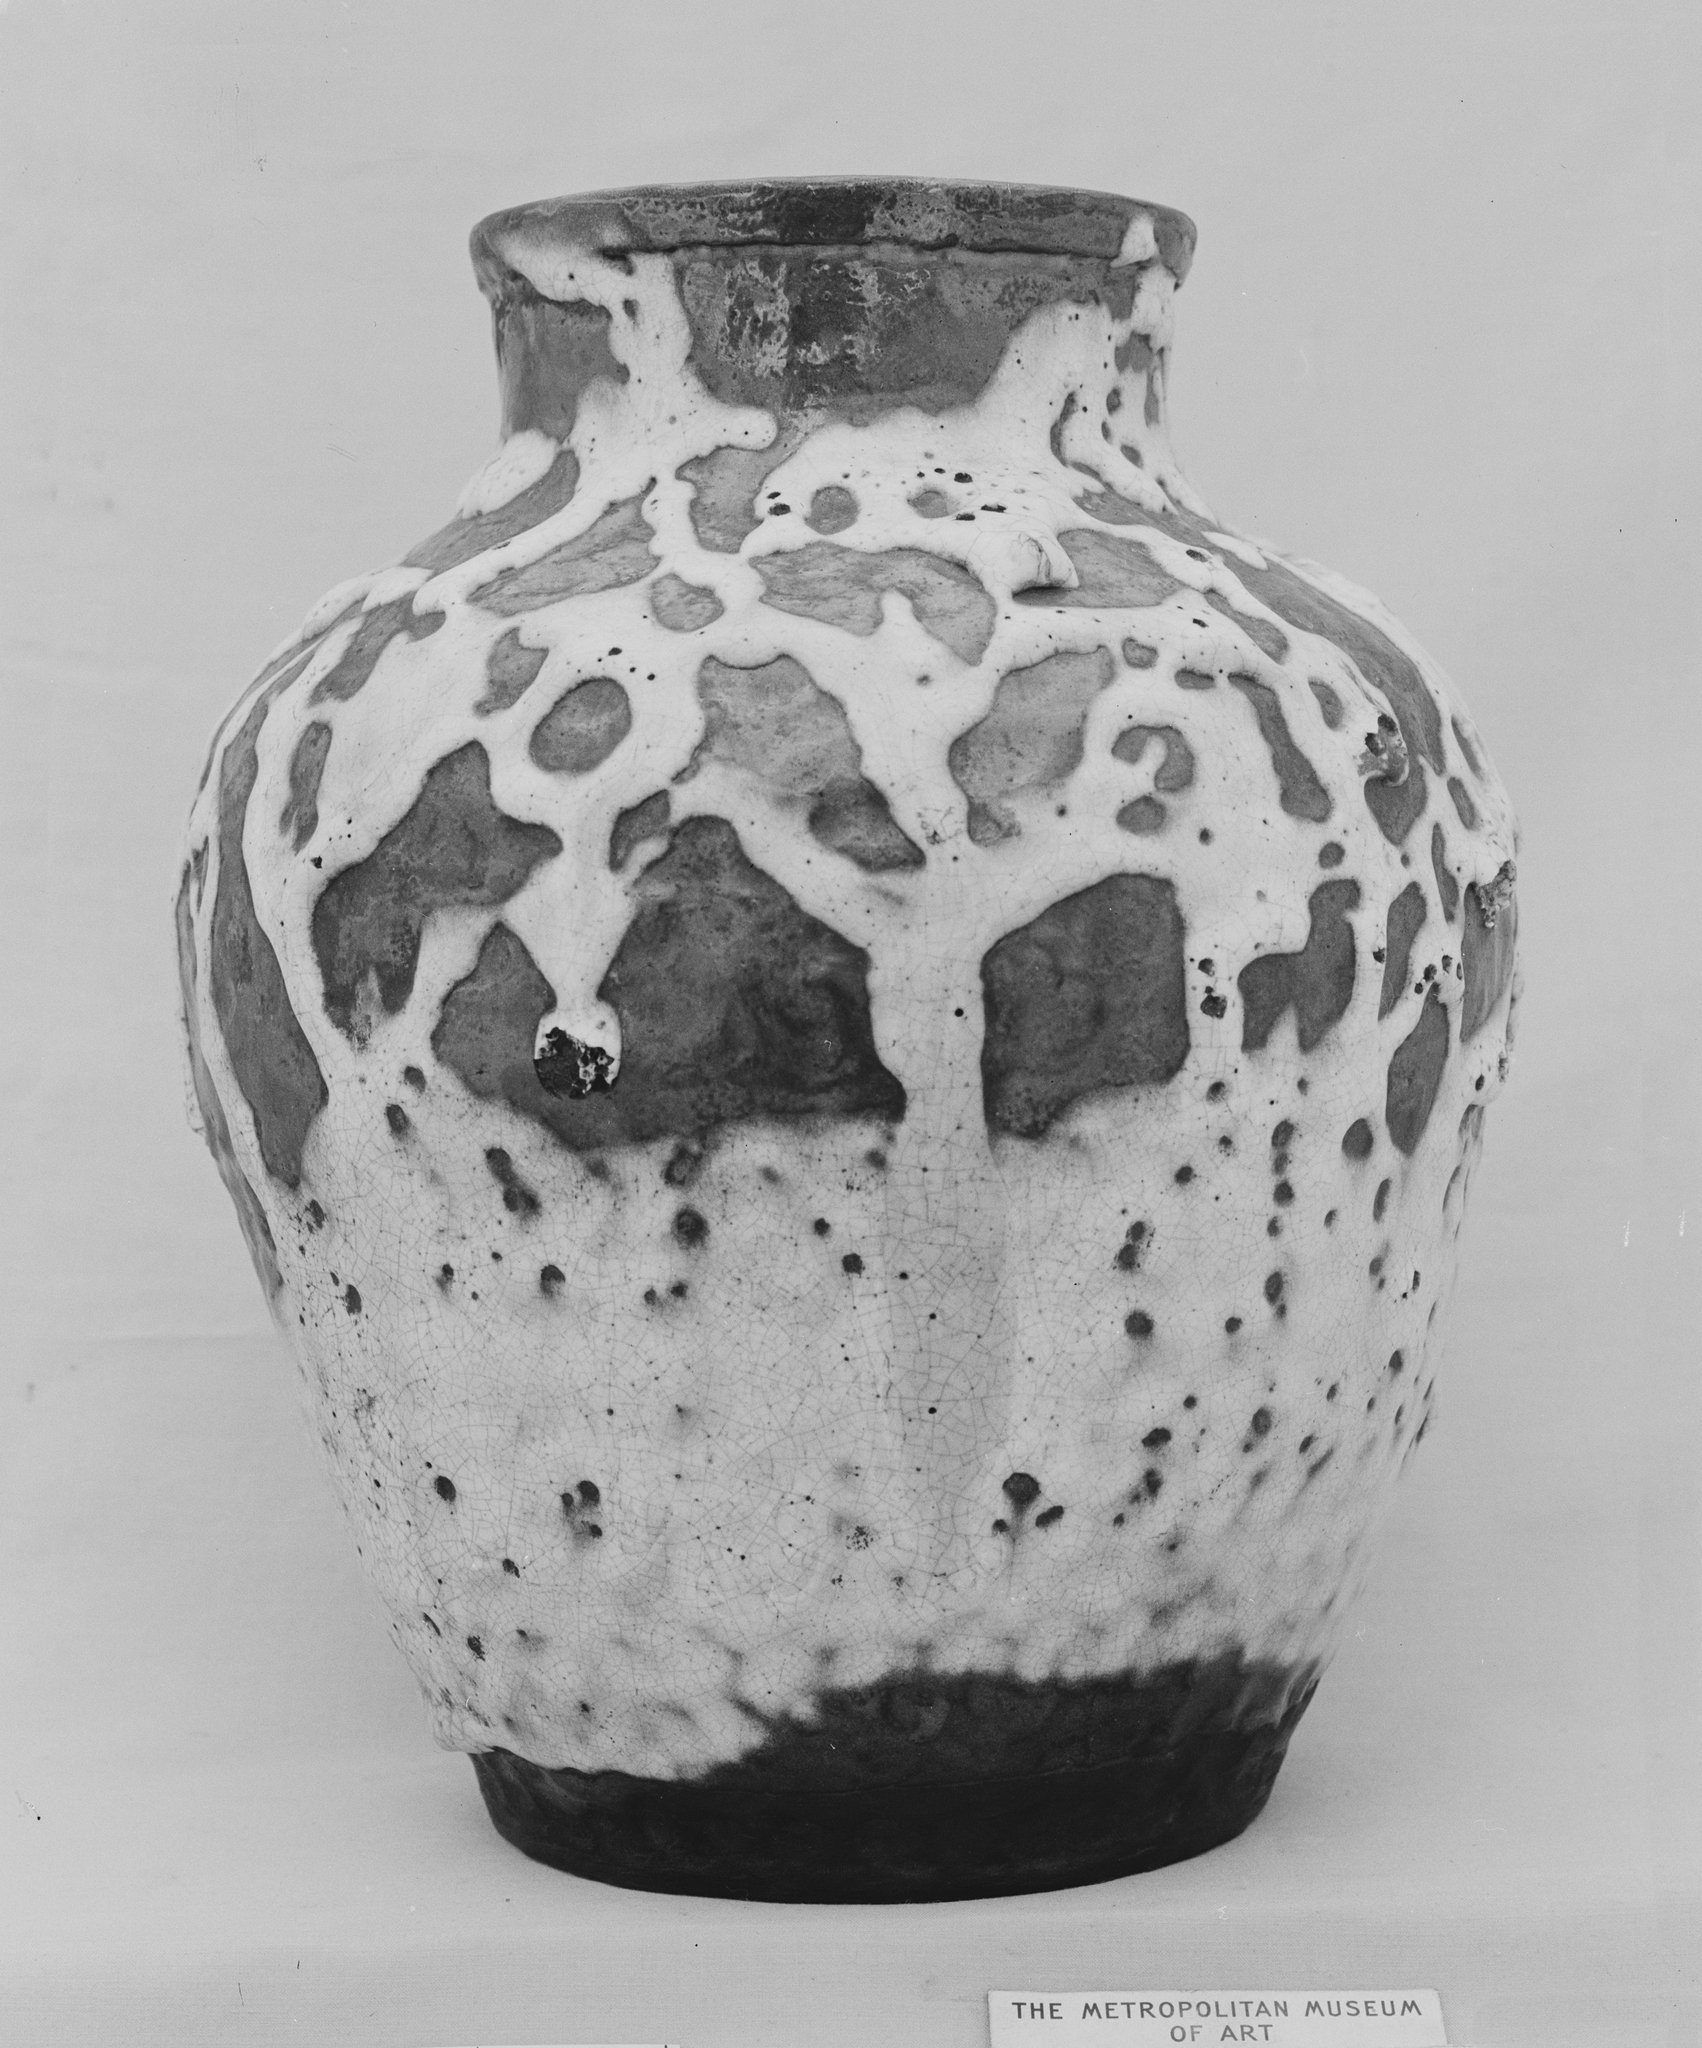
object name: jar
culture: japanese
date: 1801-1900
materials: clay, glaze